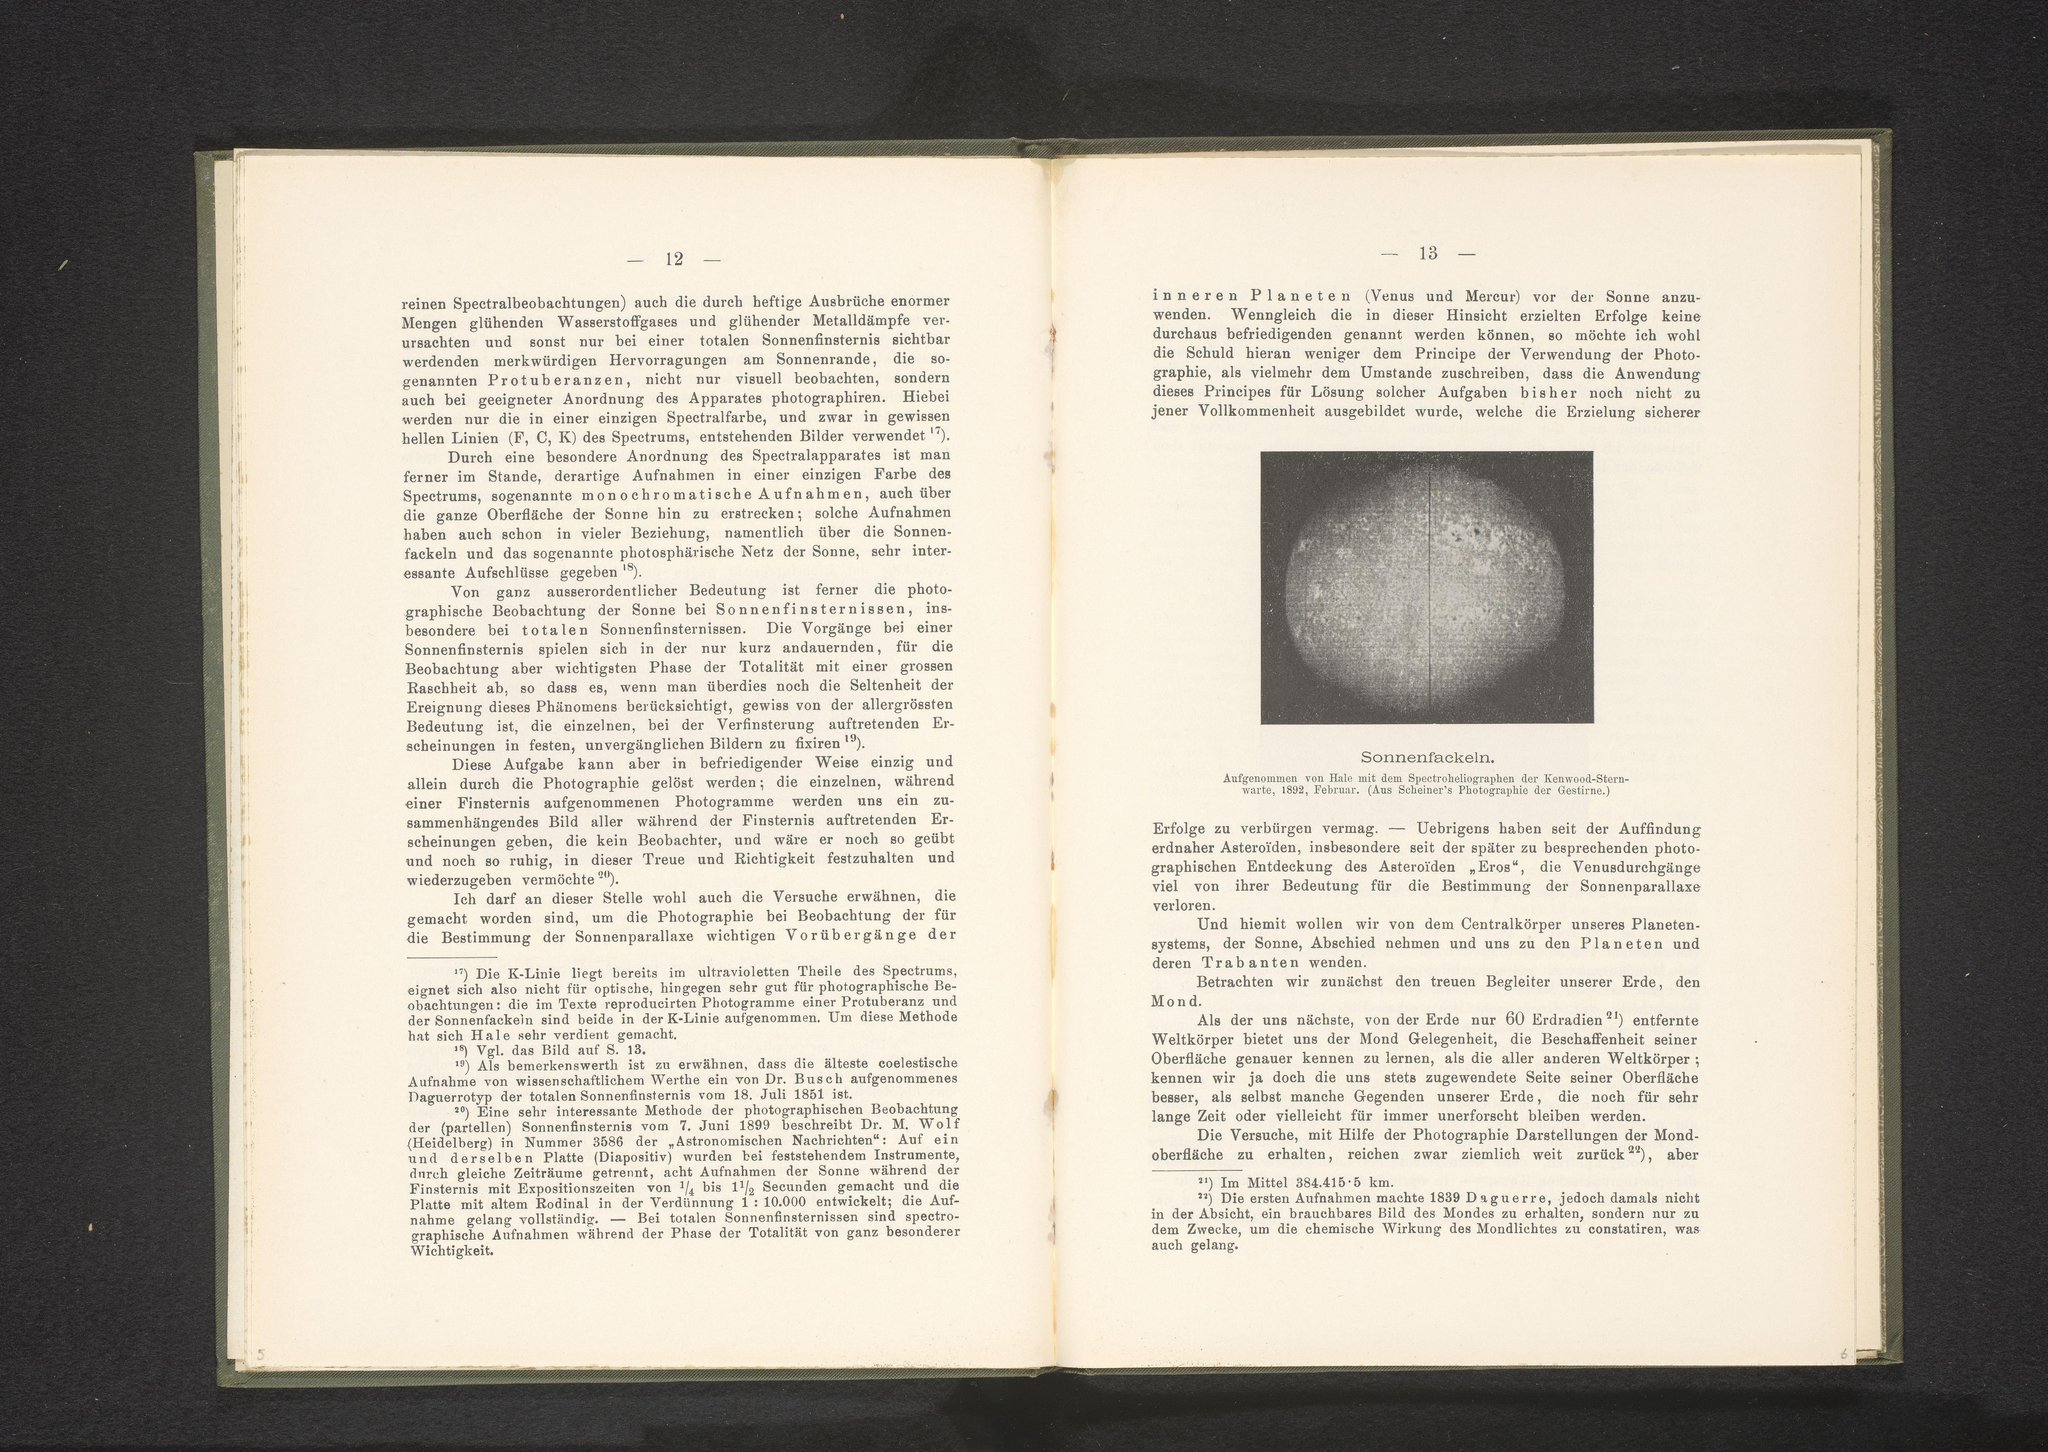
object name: page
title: Zonnevlekken op het oppervlak van de zon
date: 1802-1892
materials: paper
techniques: autotype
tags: sun-spots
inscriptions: inscription: ‘Aufgenommen von Hale mit dem Spectroheliographen der Kenwood-Sternwarte. 1892, Februar. (Aus Scheiner's Photographie der Gestirne.)’